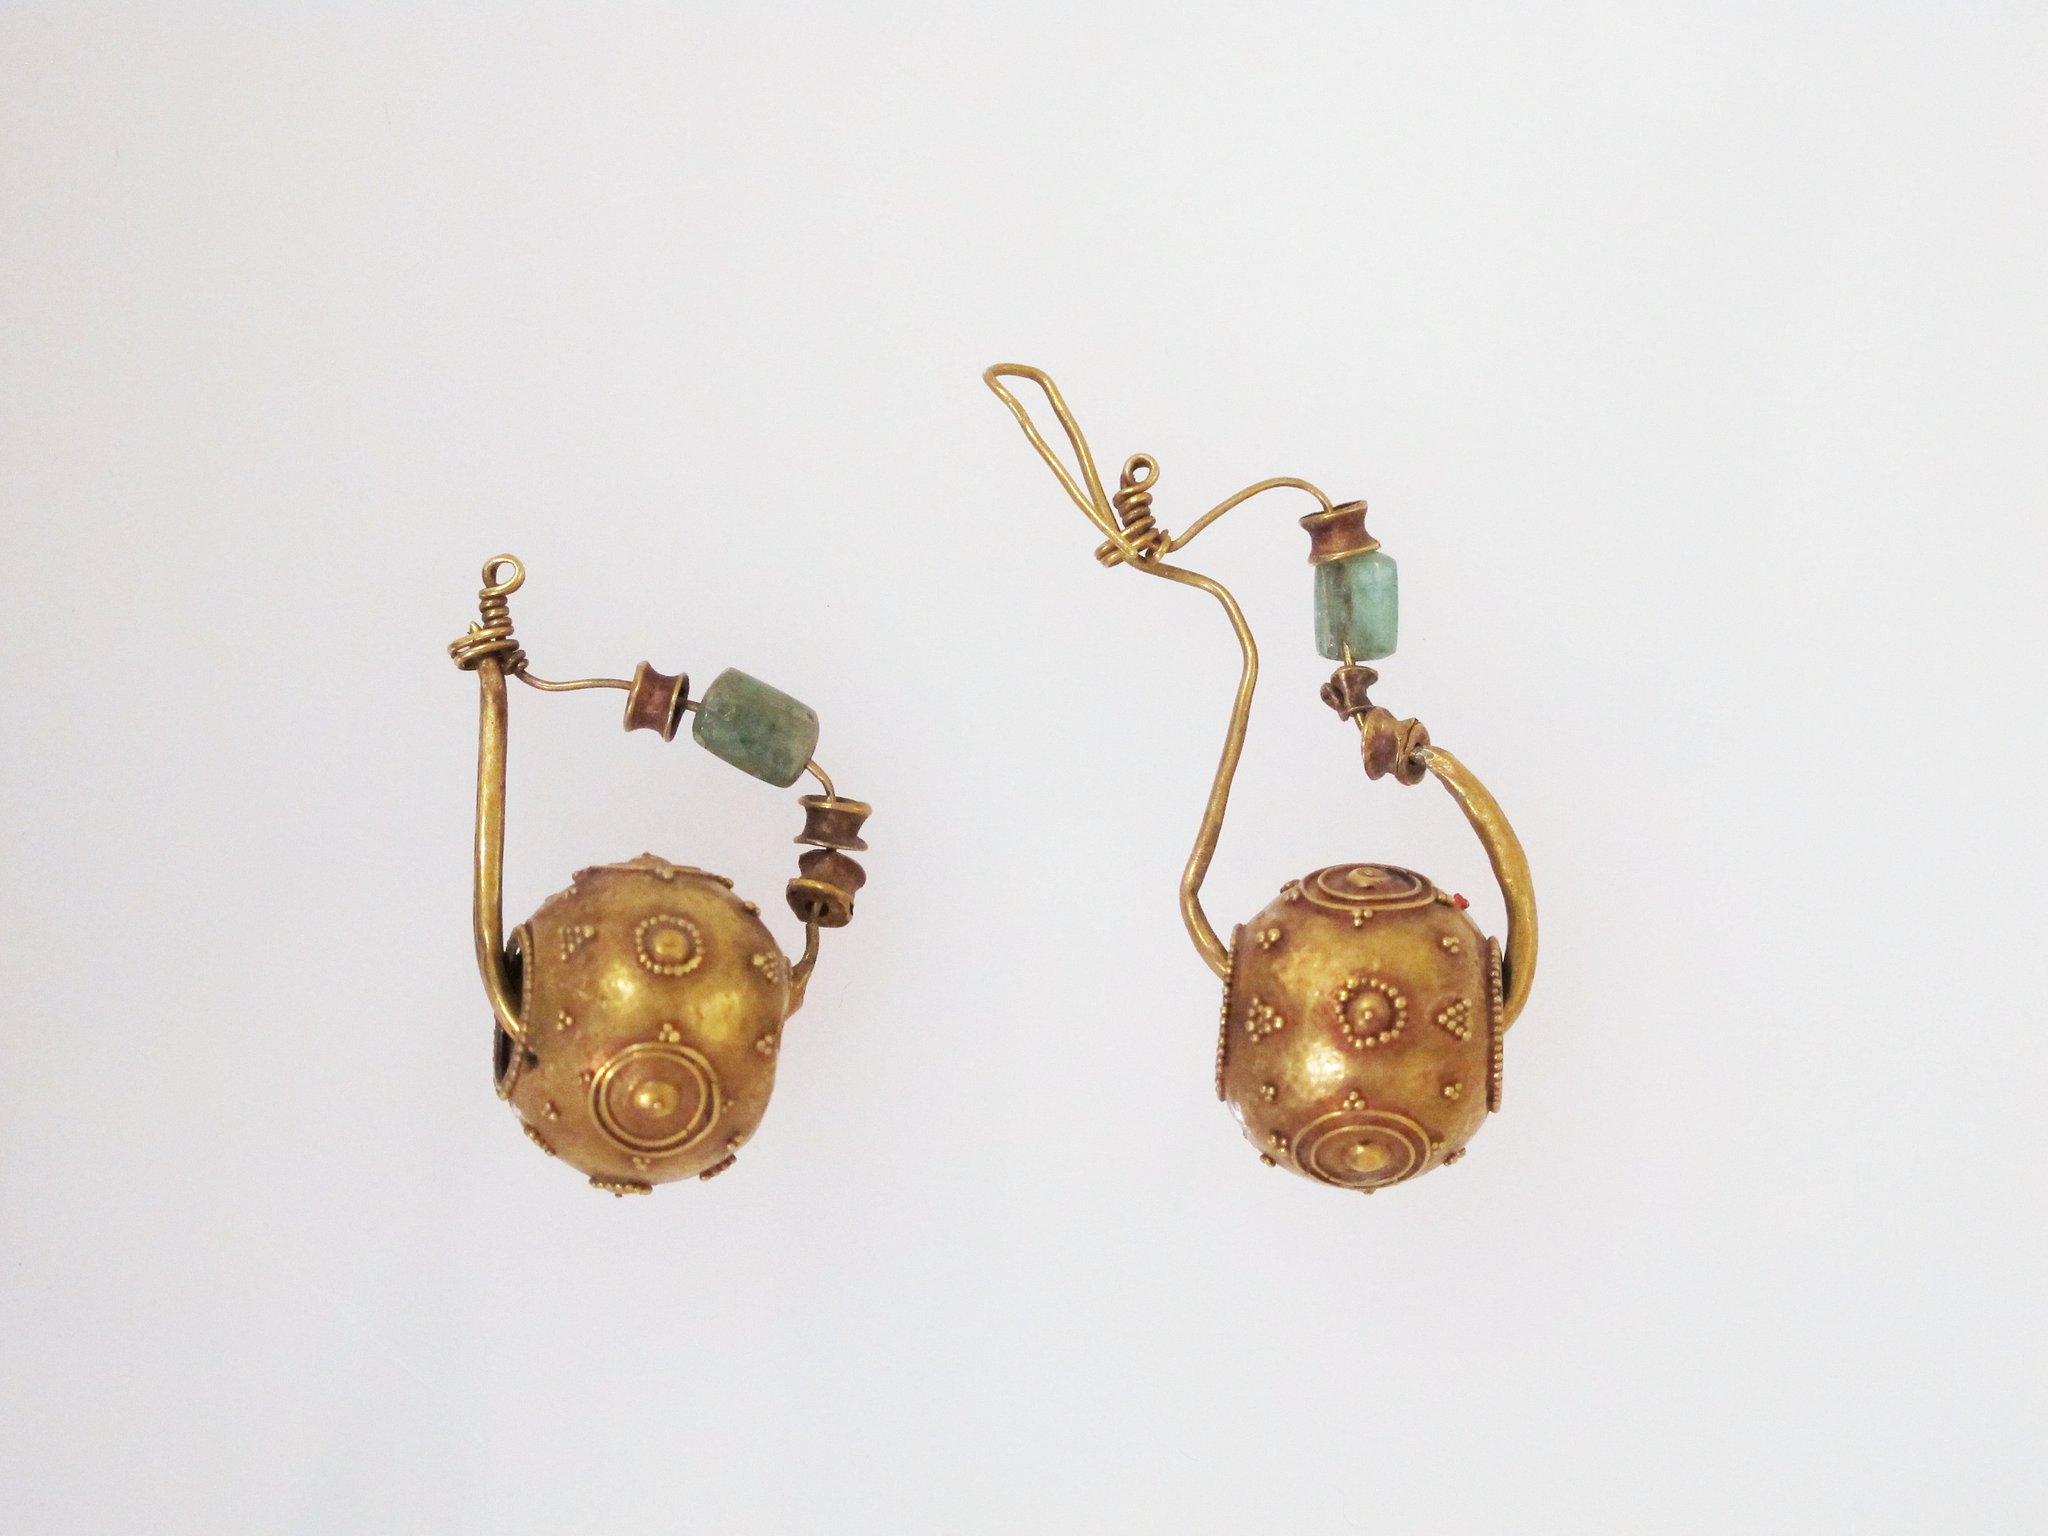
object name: earring with bead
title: Earring with beads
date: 7000 BCE-330 CE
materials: gold